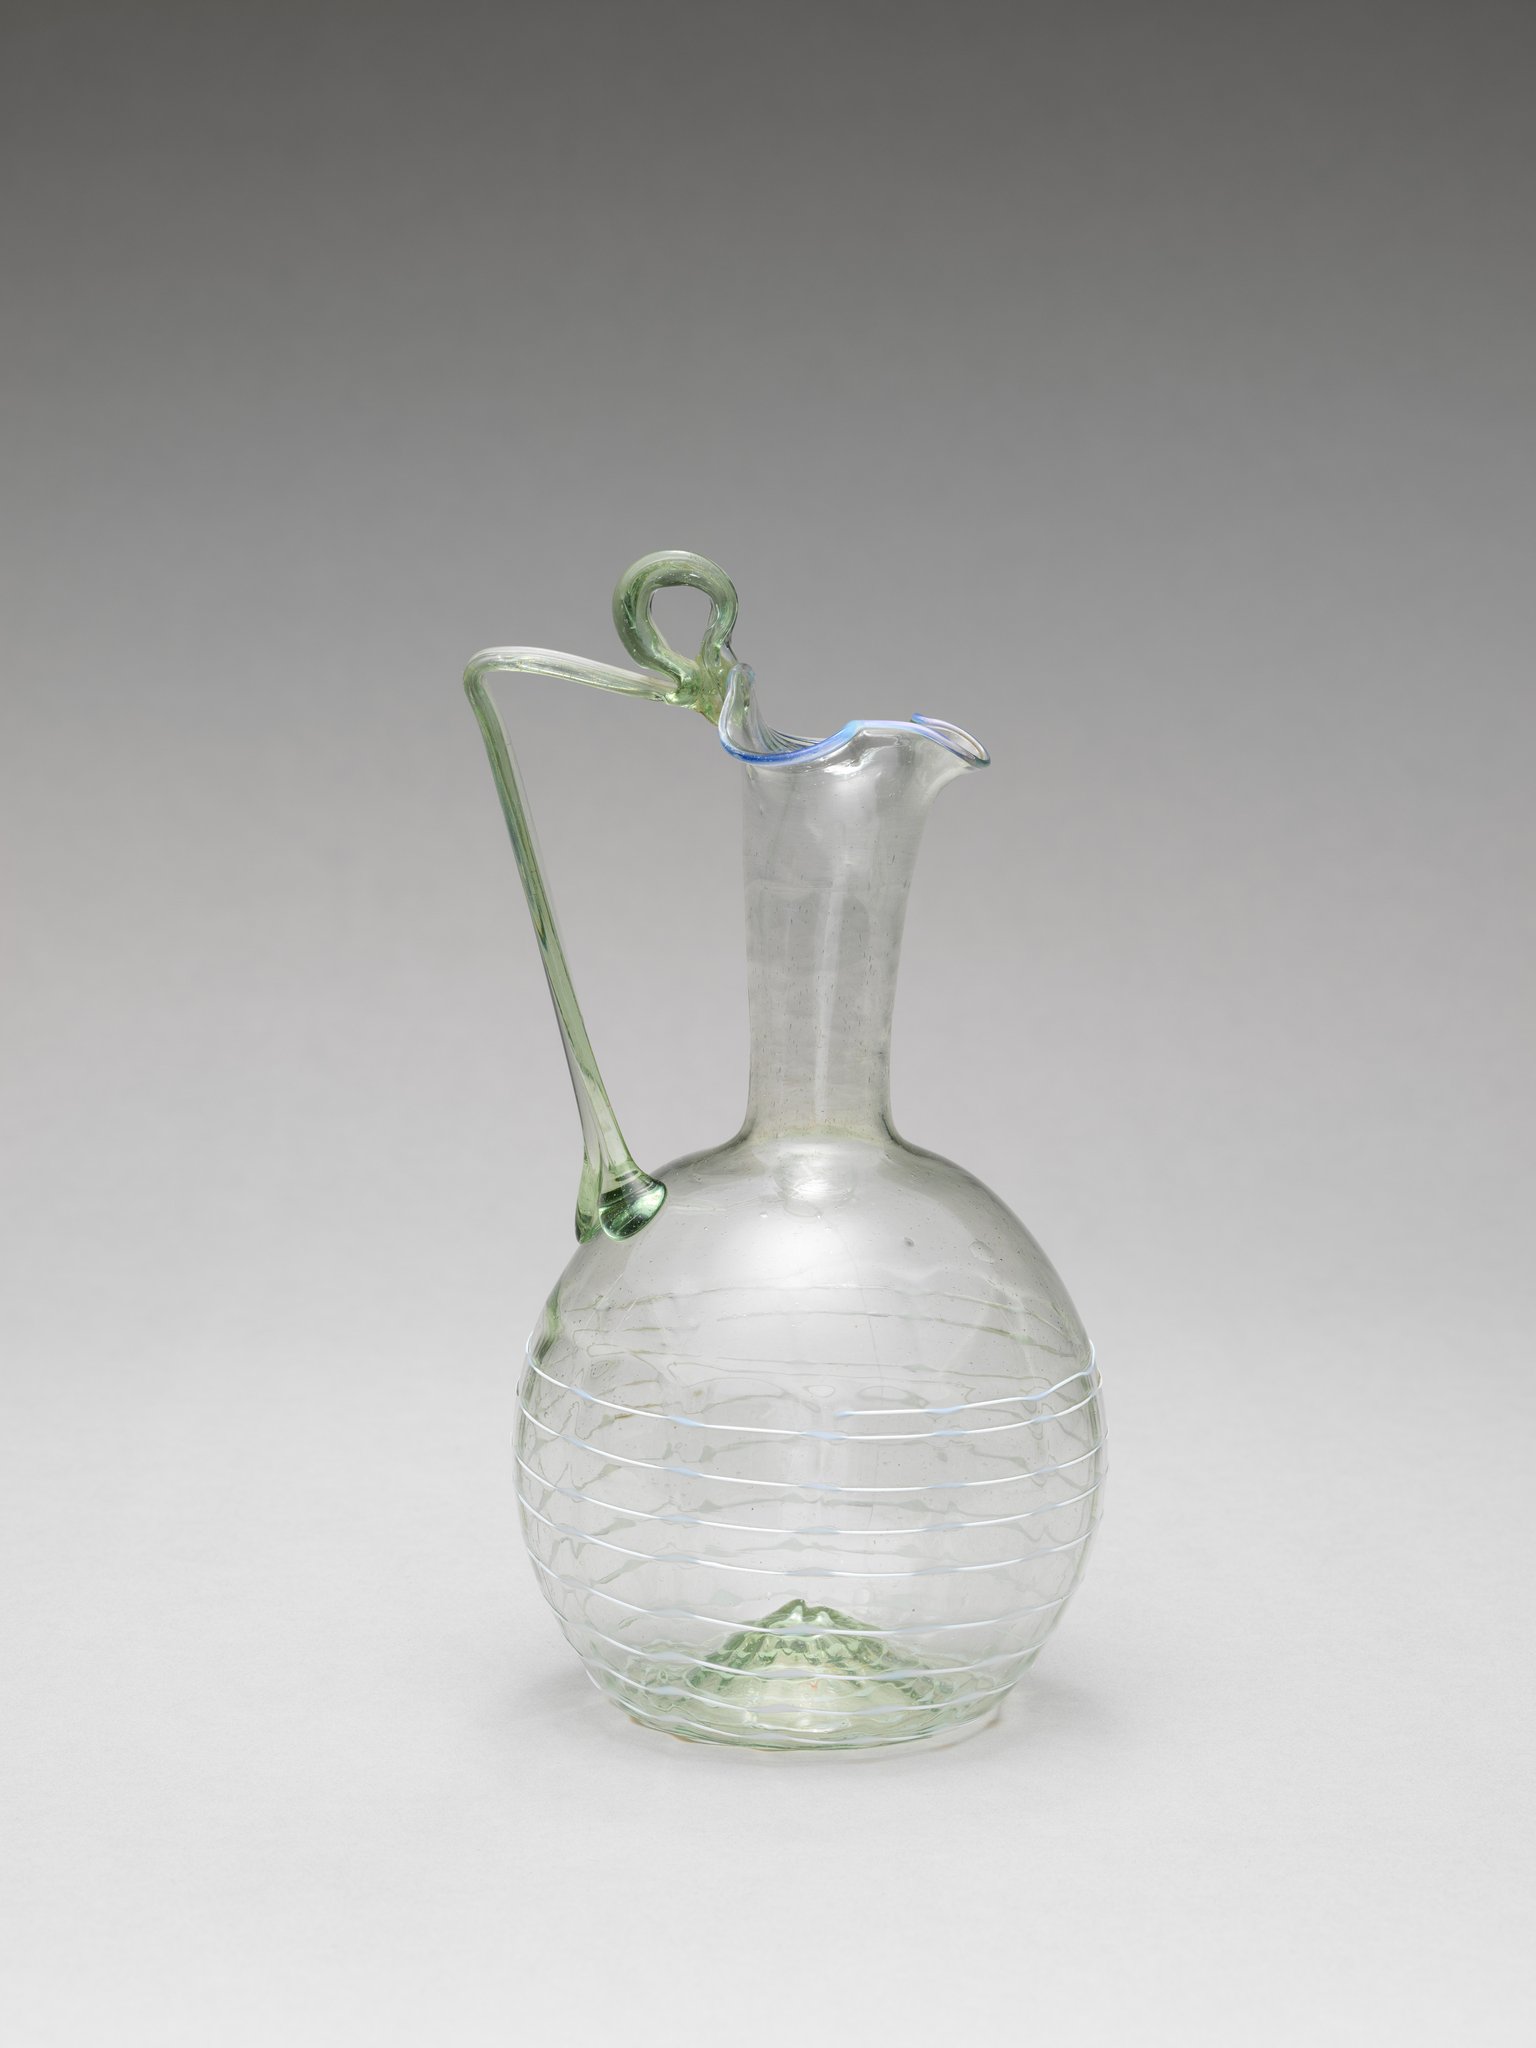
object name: ewer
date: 1601-1700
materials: glass